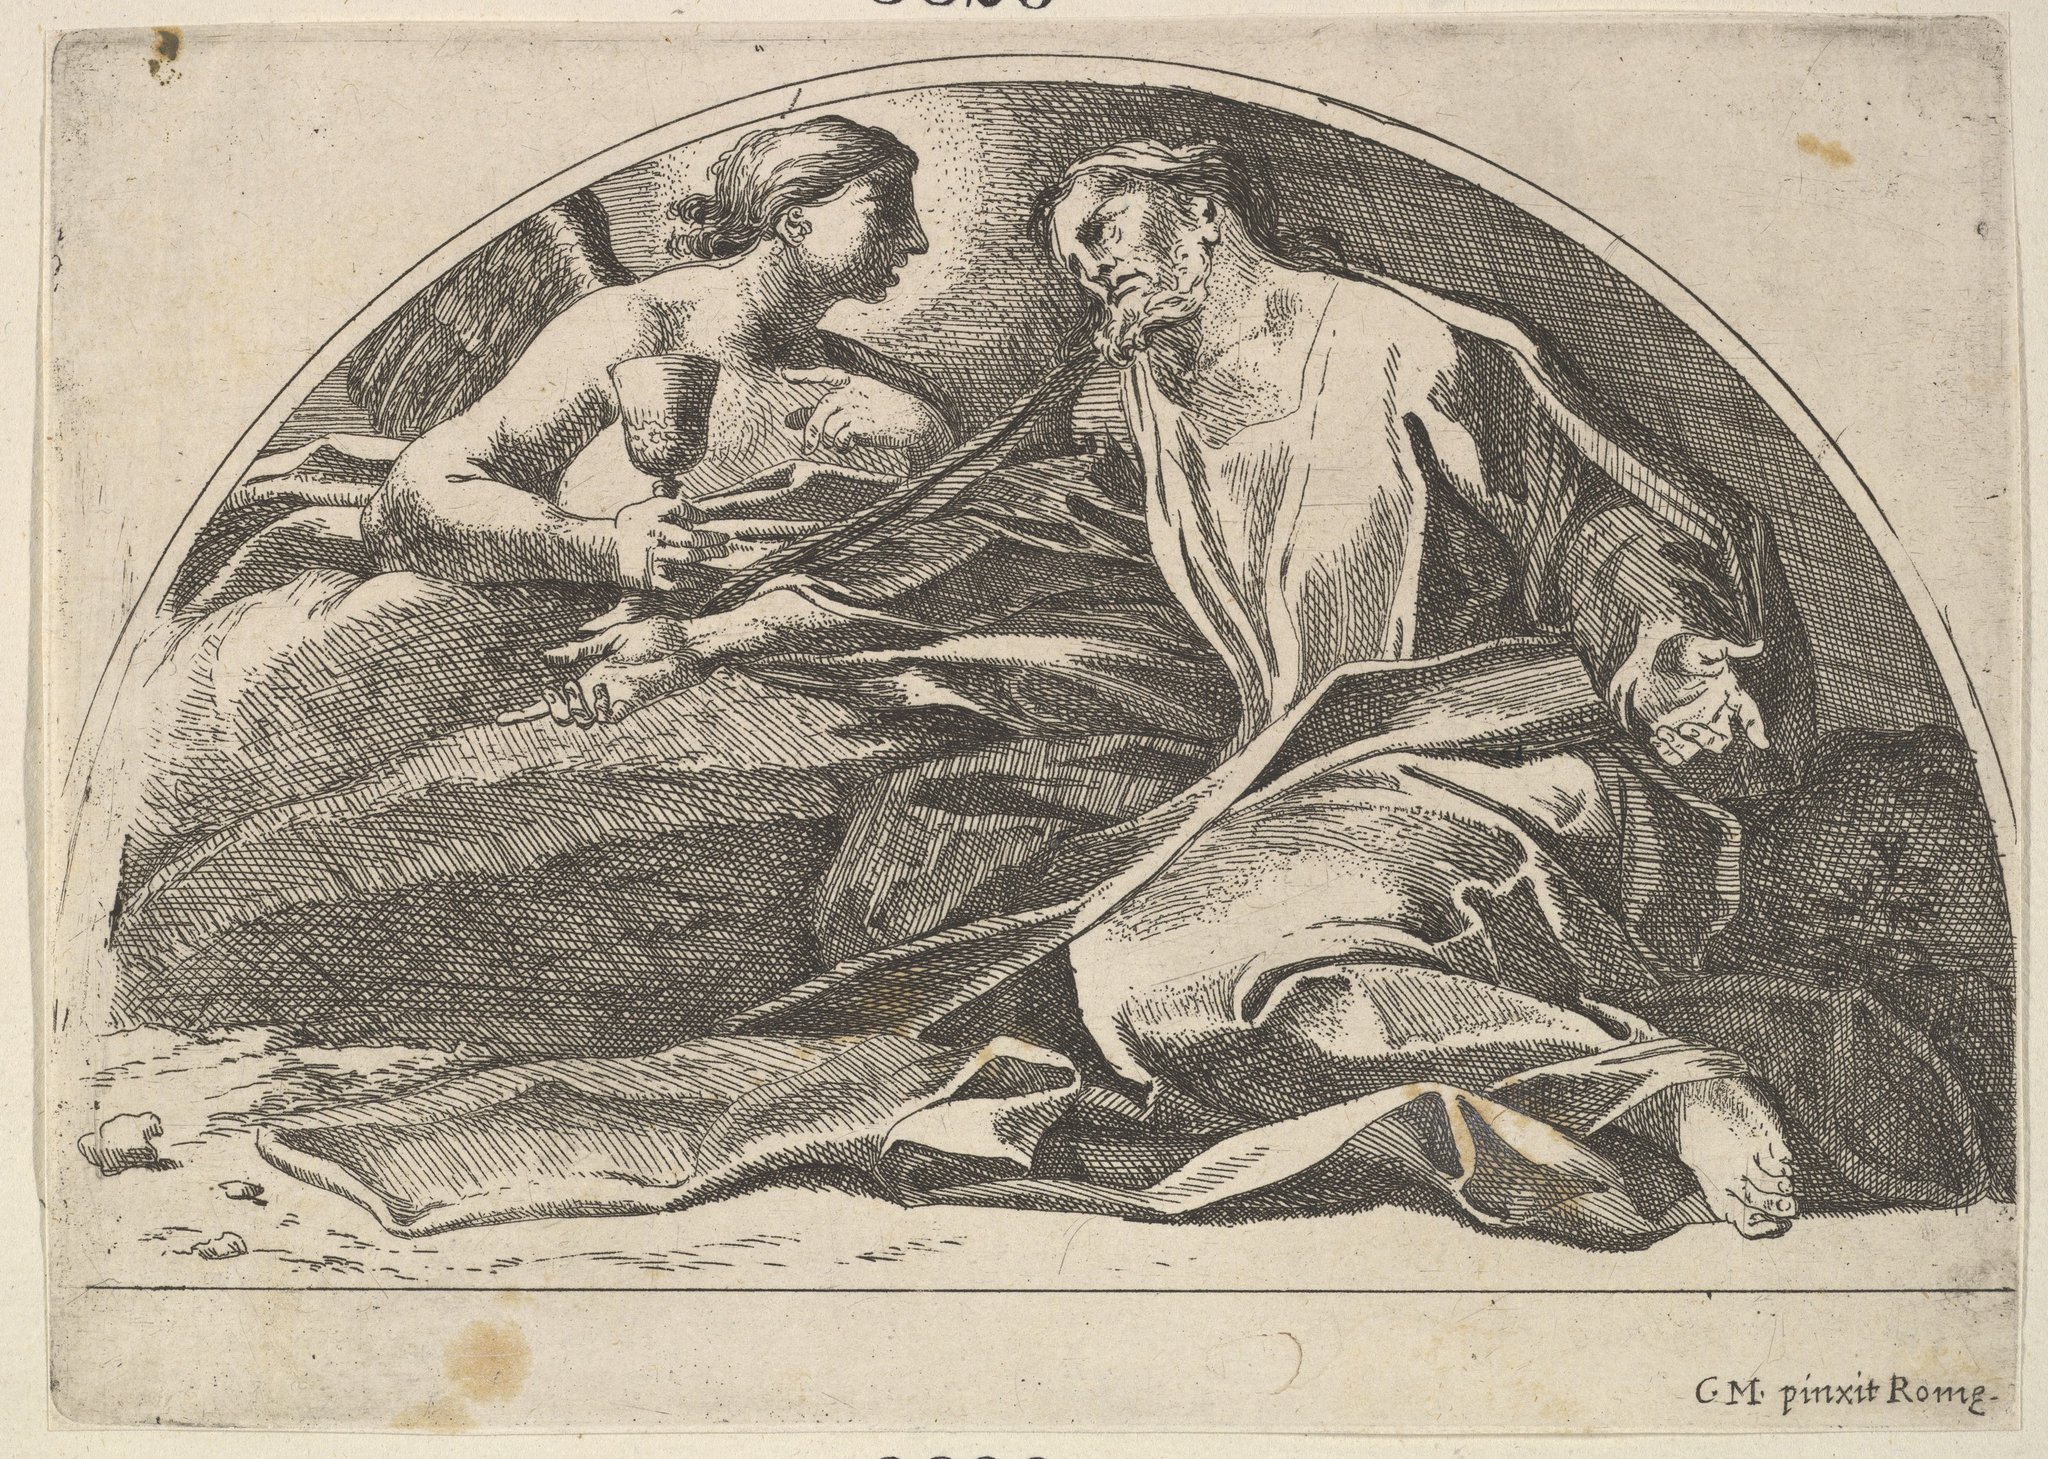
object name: print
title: Agony in the Garden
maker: robert van audenaerde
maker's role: artist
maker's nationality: flemish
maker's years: 1663-1743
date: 1680-1743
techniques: etching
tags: angels,jesus